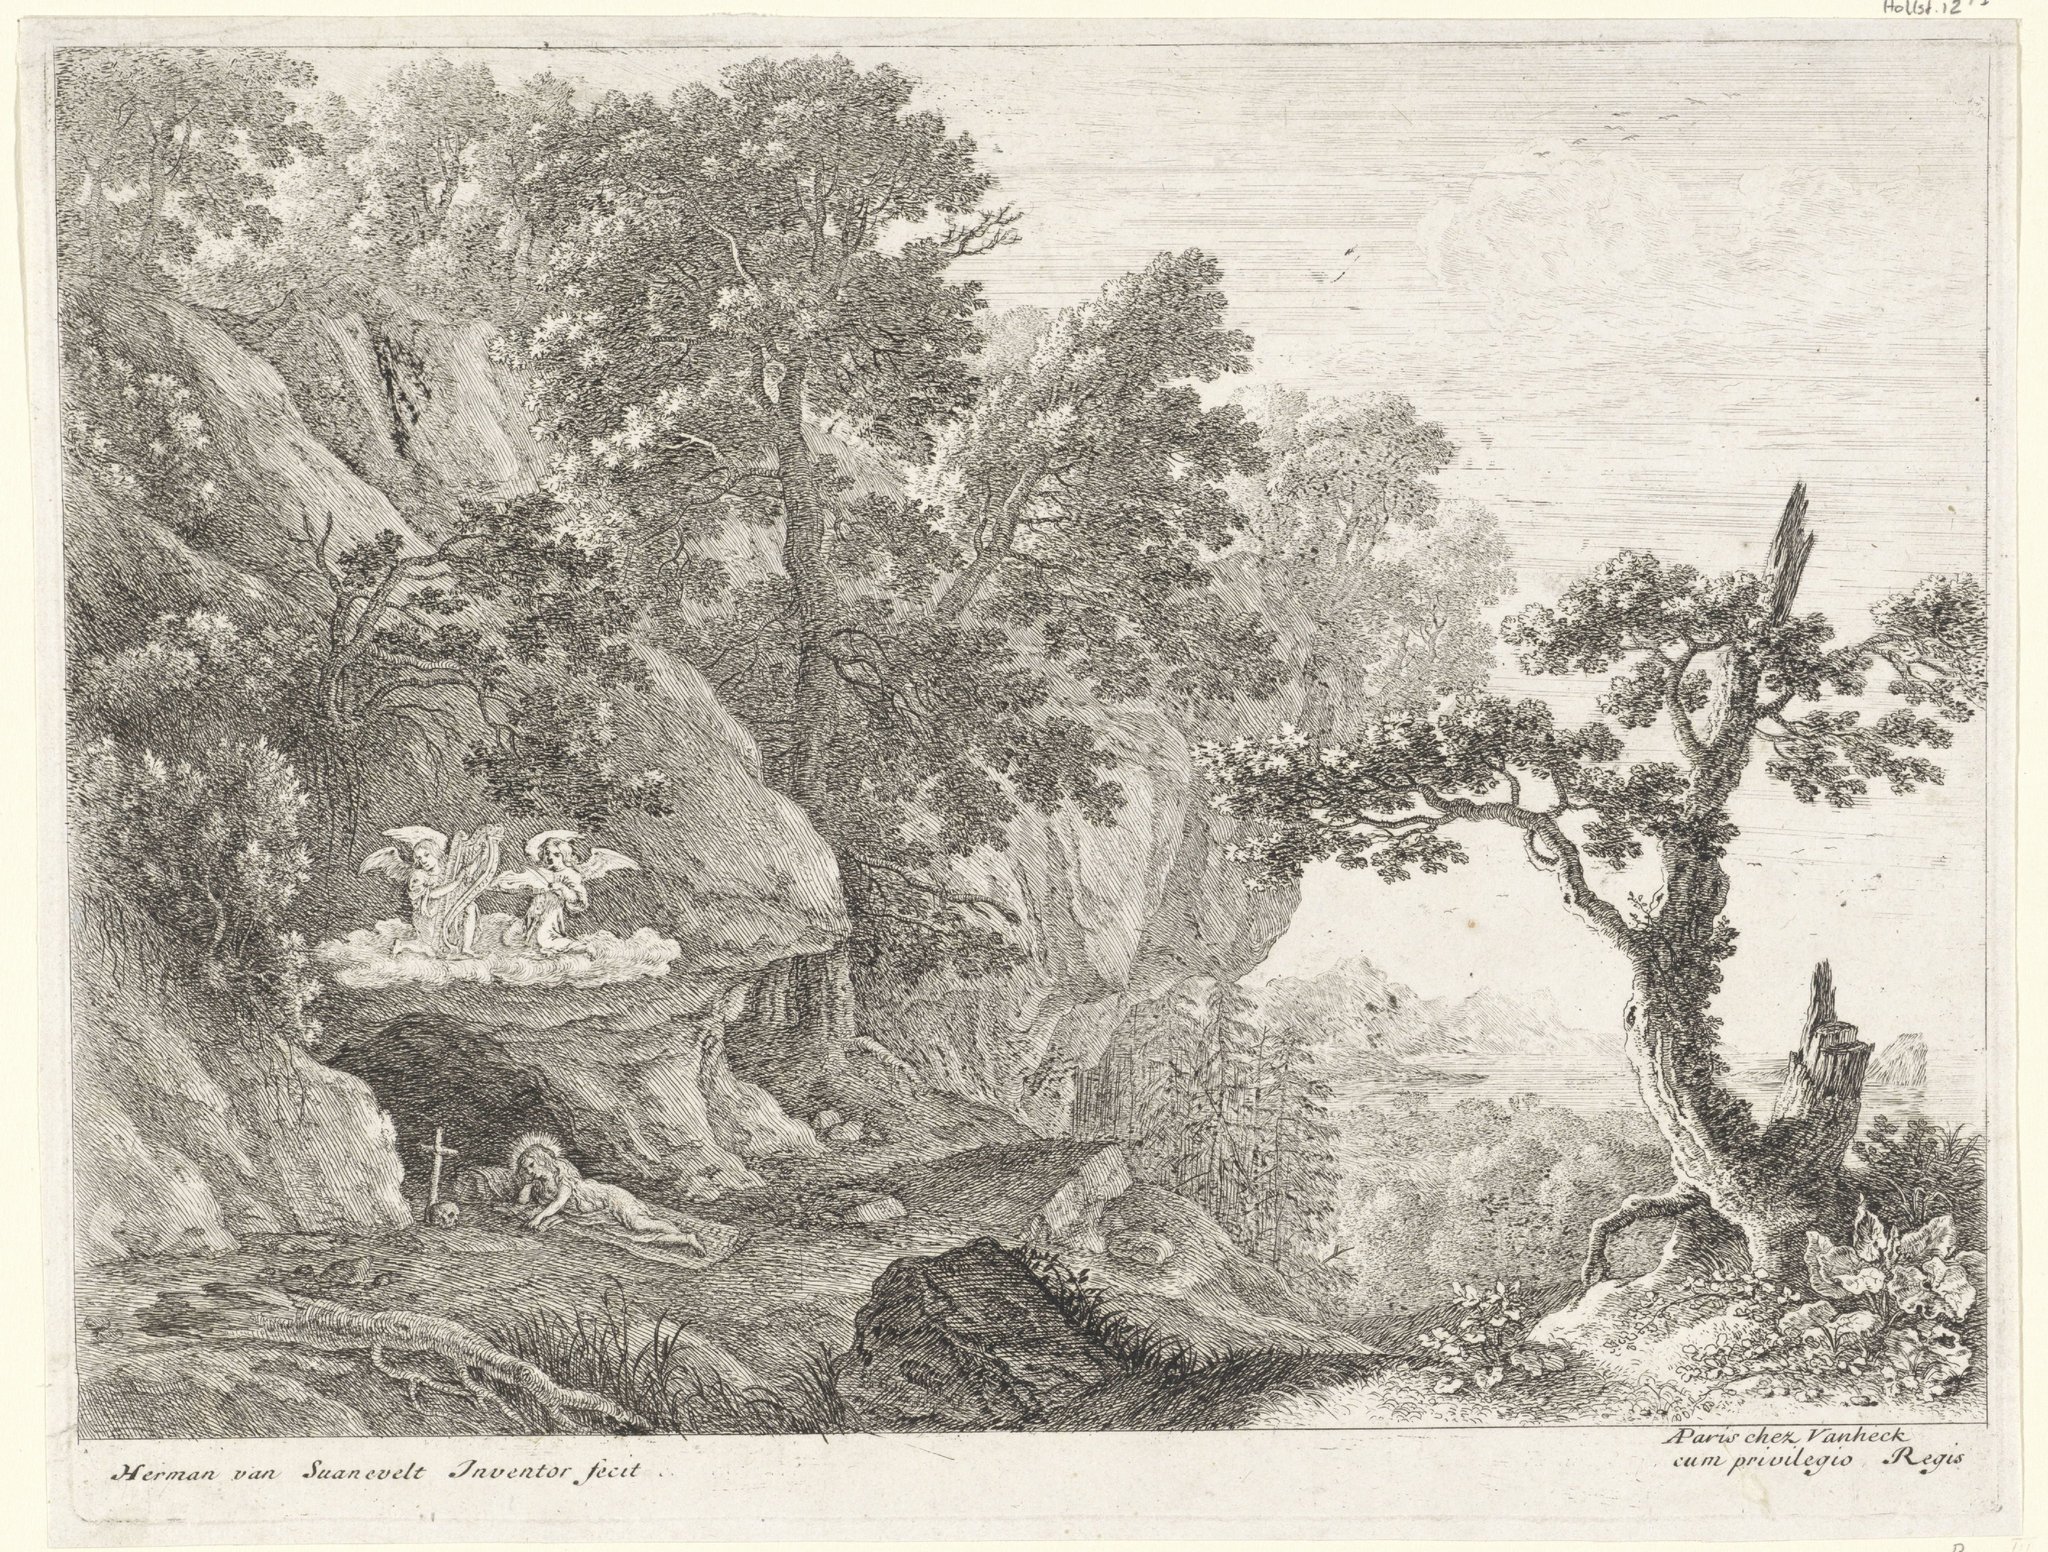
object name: print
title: Landschappen met boetvaardige heiligen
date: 1643-1655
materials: paper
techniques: etching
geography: paris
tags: the penitent st. mary magdalene (often before a cave, possibly at la sainte-baume hill): her long hair covers her (naked) body, she reads, meditates or raises her tear-filled eyes towards heaven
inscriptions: collector's mark: Lugt 2228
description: Maria Magdalena ligt voor een grot op een kleed. Naast haar zijn een schedel en een kruis te zien, haar attributen. Op een wolk boven haar knielen twee musicerende engelen. De linkerengel bespeelt een harp en de rechterengel een viool. Het omringende landschap is met veel boompartijen gestoffeerd.